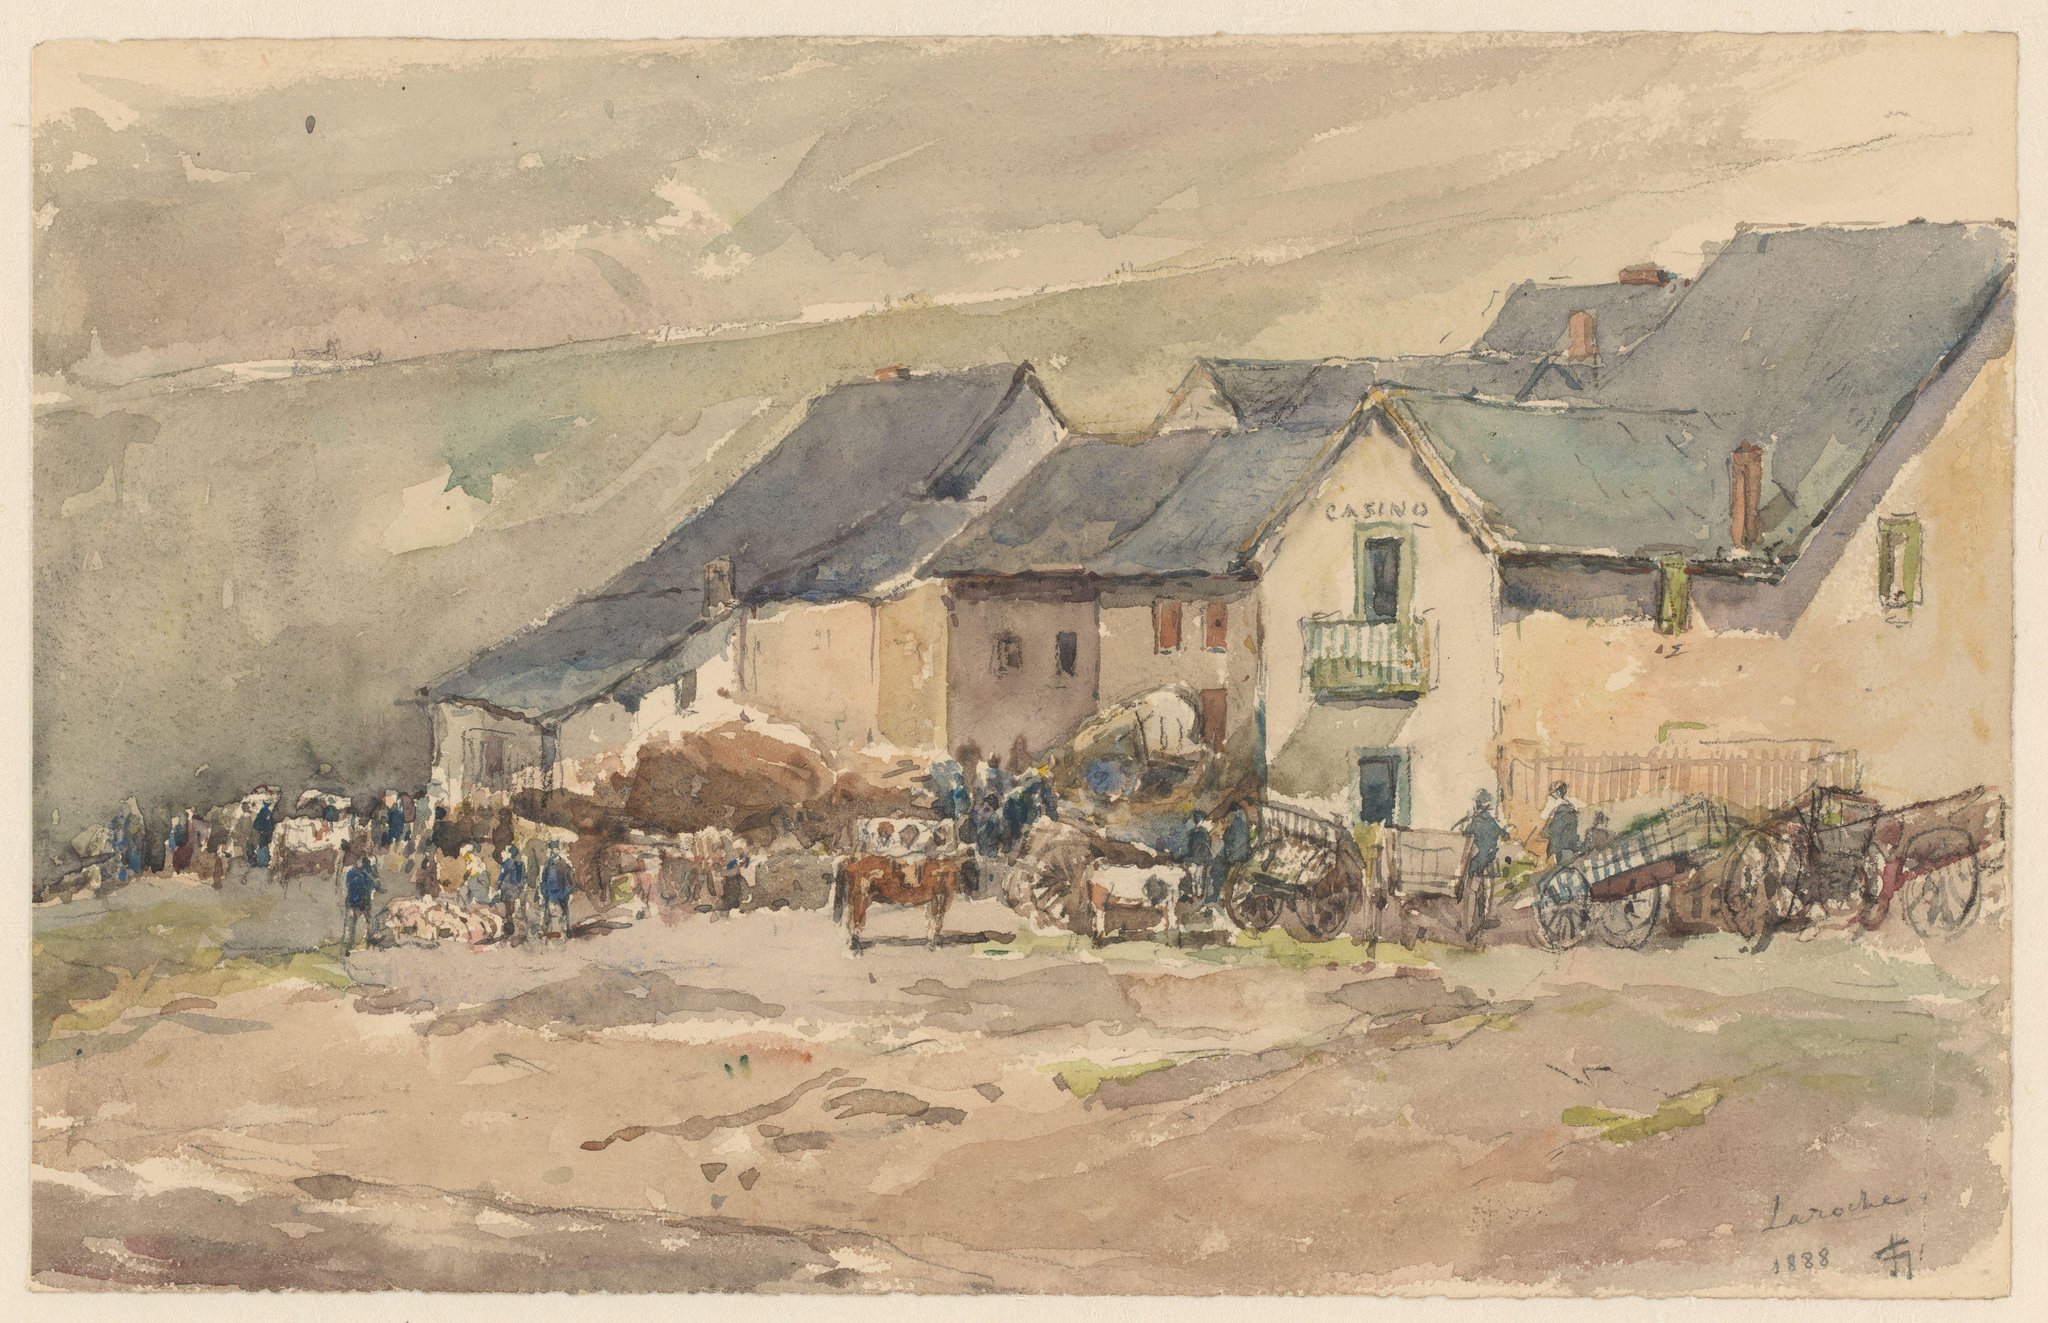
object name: drawing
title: Dorpstafereel te Laroche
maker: carel nicolaas storm van s-gravesande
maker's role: draughtsman, print maker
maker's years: 1841-1924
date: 1888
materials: chalk, paper, watercolor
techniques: brush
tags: prospect of village, silhouette of village, france, belgium